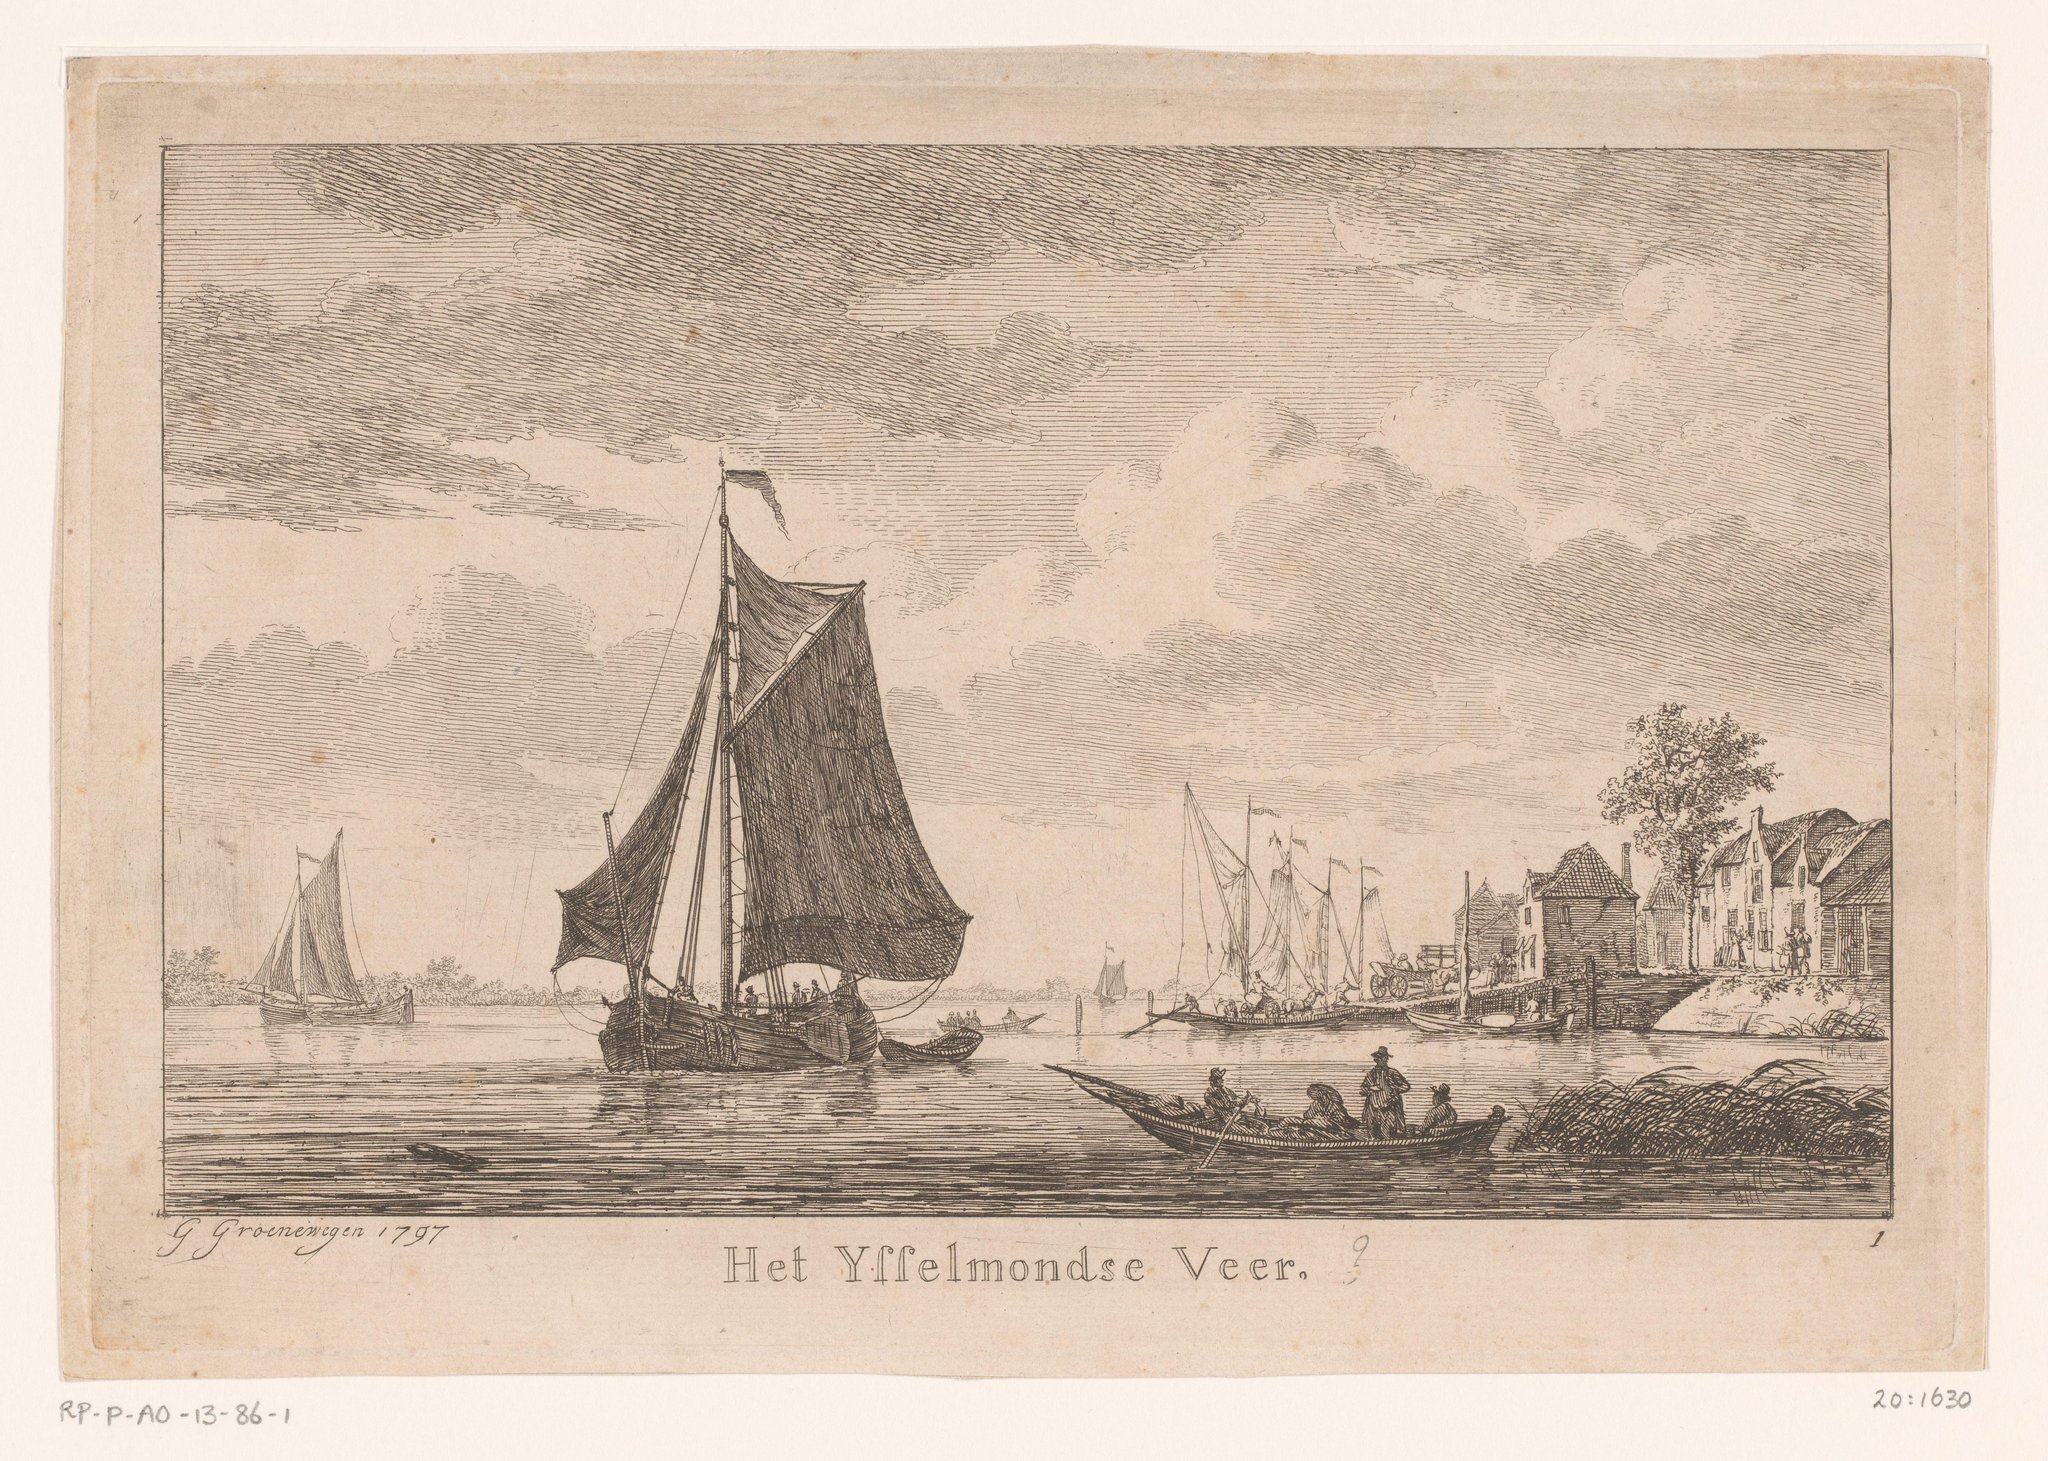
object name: print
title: Gezichten op de Maas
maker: gerrit groenewegen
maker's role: draughtsman, print maker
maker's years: 1754-1826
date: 1797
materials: paper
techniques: etching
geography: rotterdam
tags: sailing-ship, sailing-boat, rowing-boat, canoe, etc., ferry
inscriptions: collector's mark: Lugt 2233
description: Gezicht op de Maas en het IJsselmondse Veer bij Kralingen, met op de voorgrond een roeiboot en een platbodem. Rechts de Schaardijk. Rechtsonder genummerd: 1. Deze prent maakt deel uit van een serie van zes prenten met Maasgezichten.